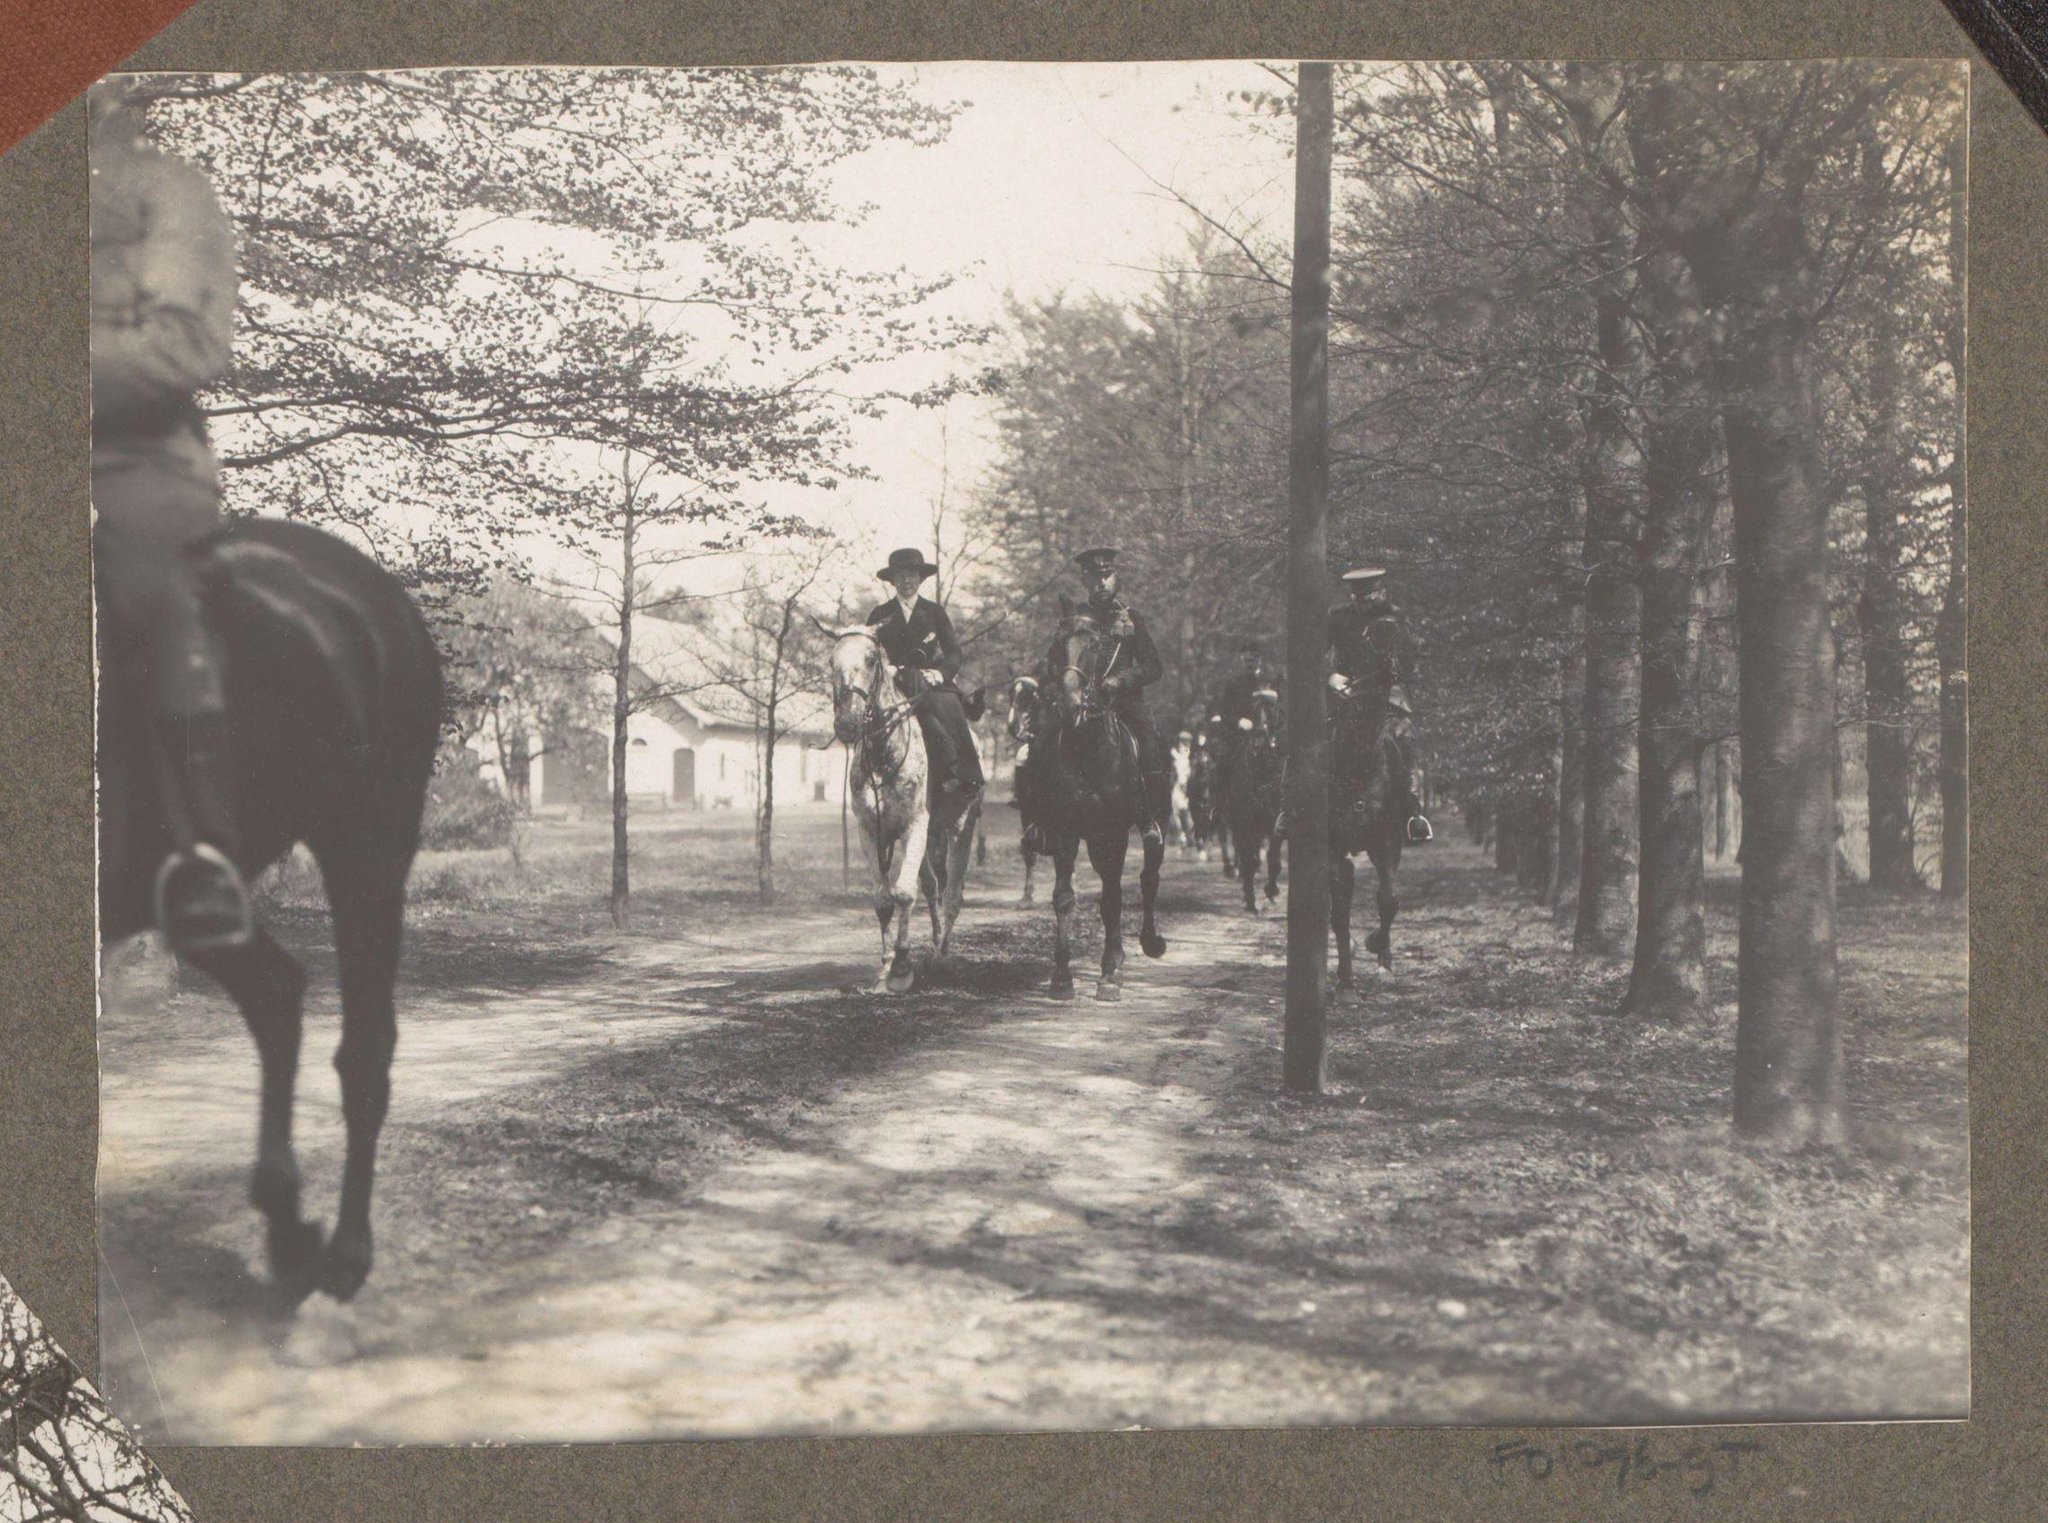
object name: photograph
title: Ruitertafereel op Koninklijke Houtvesterij Het Loo: ruiters op landweg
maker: Anonymous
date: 1900-1925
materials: photographic support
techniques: gelatin silver print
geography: het loo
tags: riding a horse, ass, or mule; rider, horseman, hunting, chase, hunting-ground, forest path or lane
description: Onderdeel van Fotoalbum van de heer Brams, opperhoutvester van koningin Wilhelmina op Koninklijke Houtvesterij Het Loo.